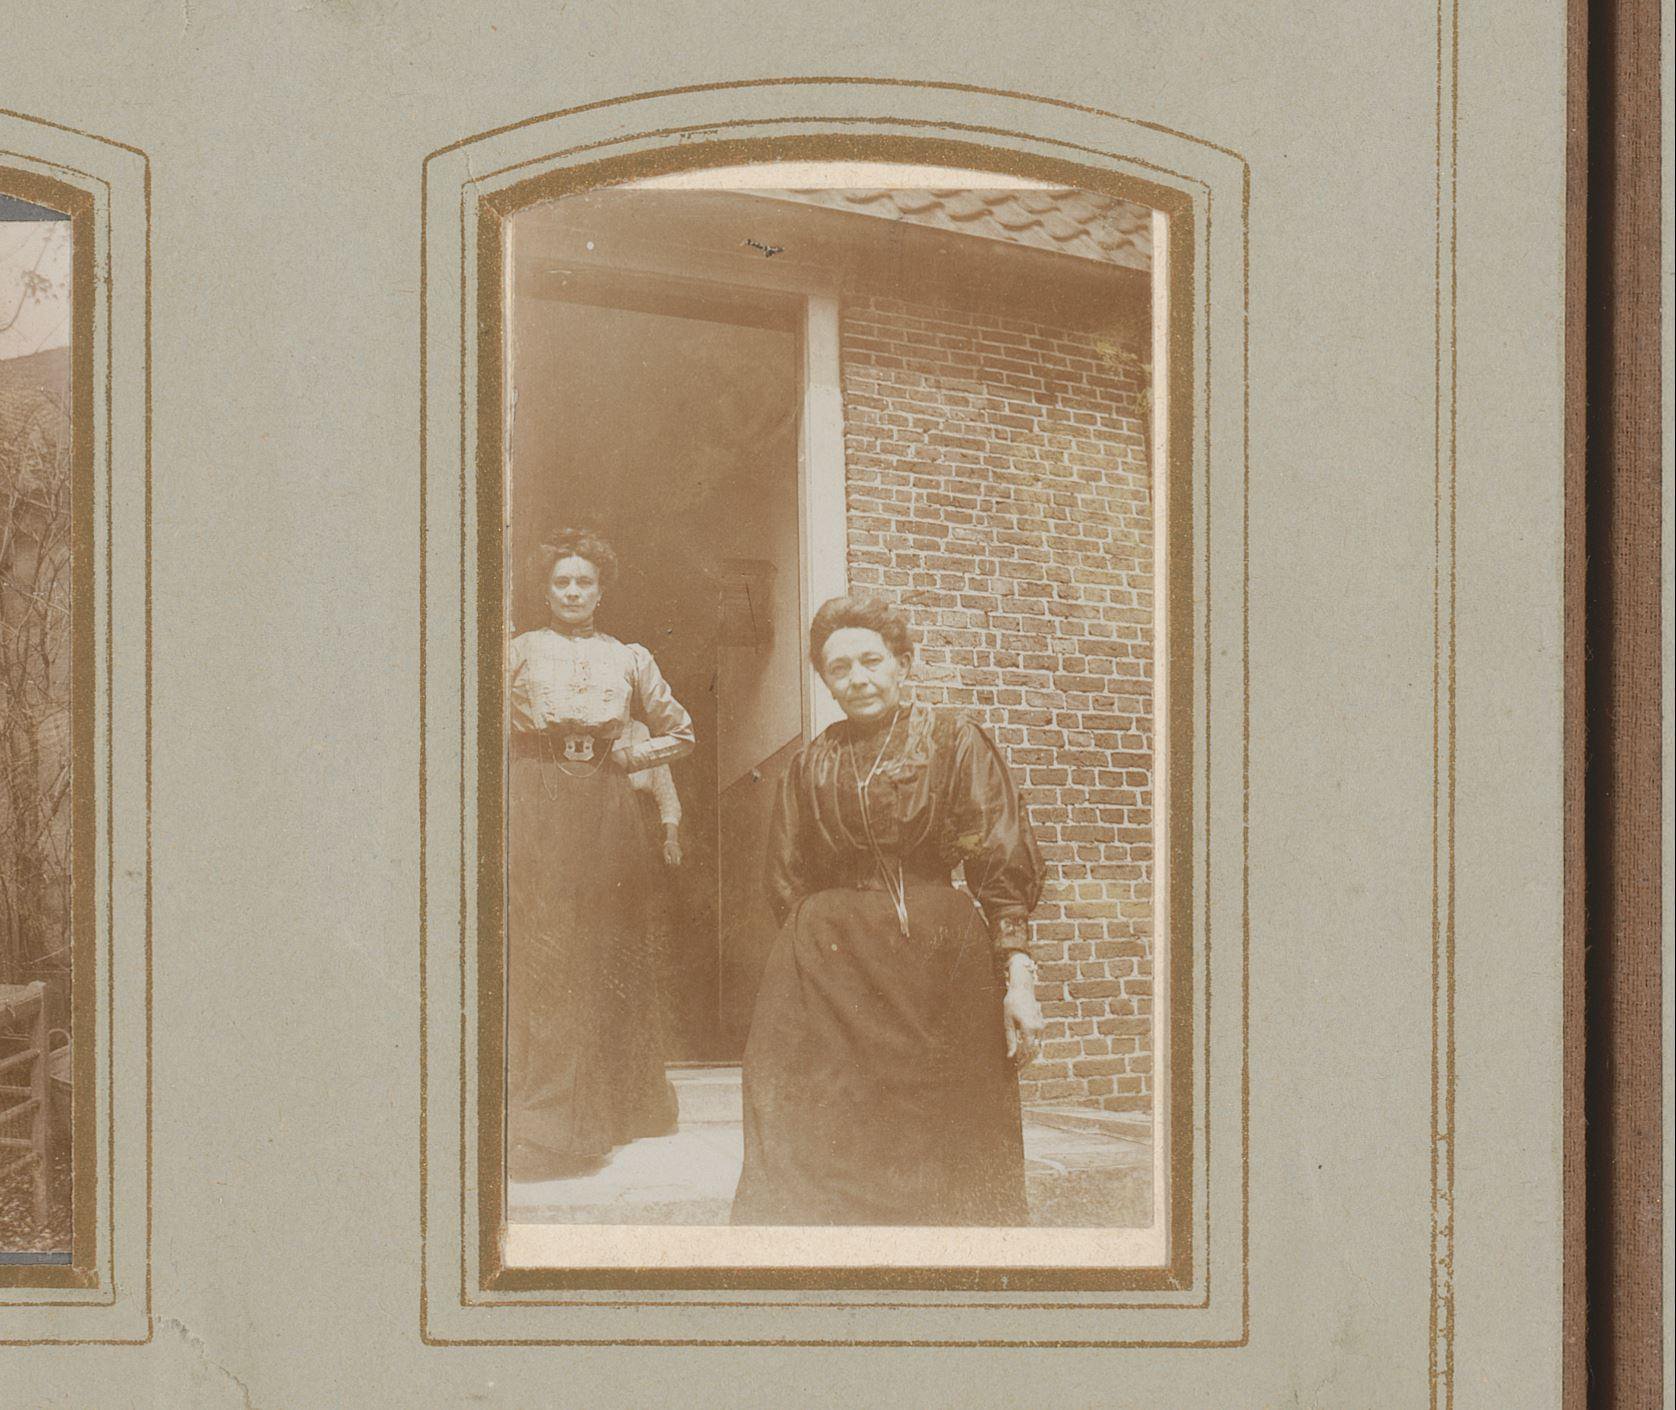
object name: carte de visite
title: Portret van een vrouw voor een huis, met op de achtergrond een andere vrouw in een deuropening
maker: Anonymous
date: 1880-1920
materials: cardboard, photographic support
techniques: collodion silver print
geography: netherlands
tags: urban housing, adult woman, historical persons - bb - woman, threshold